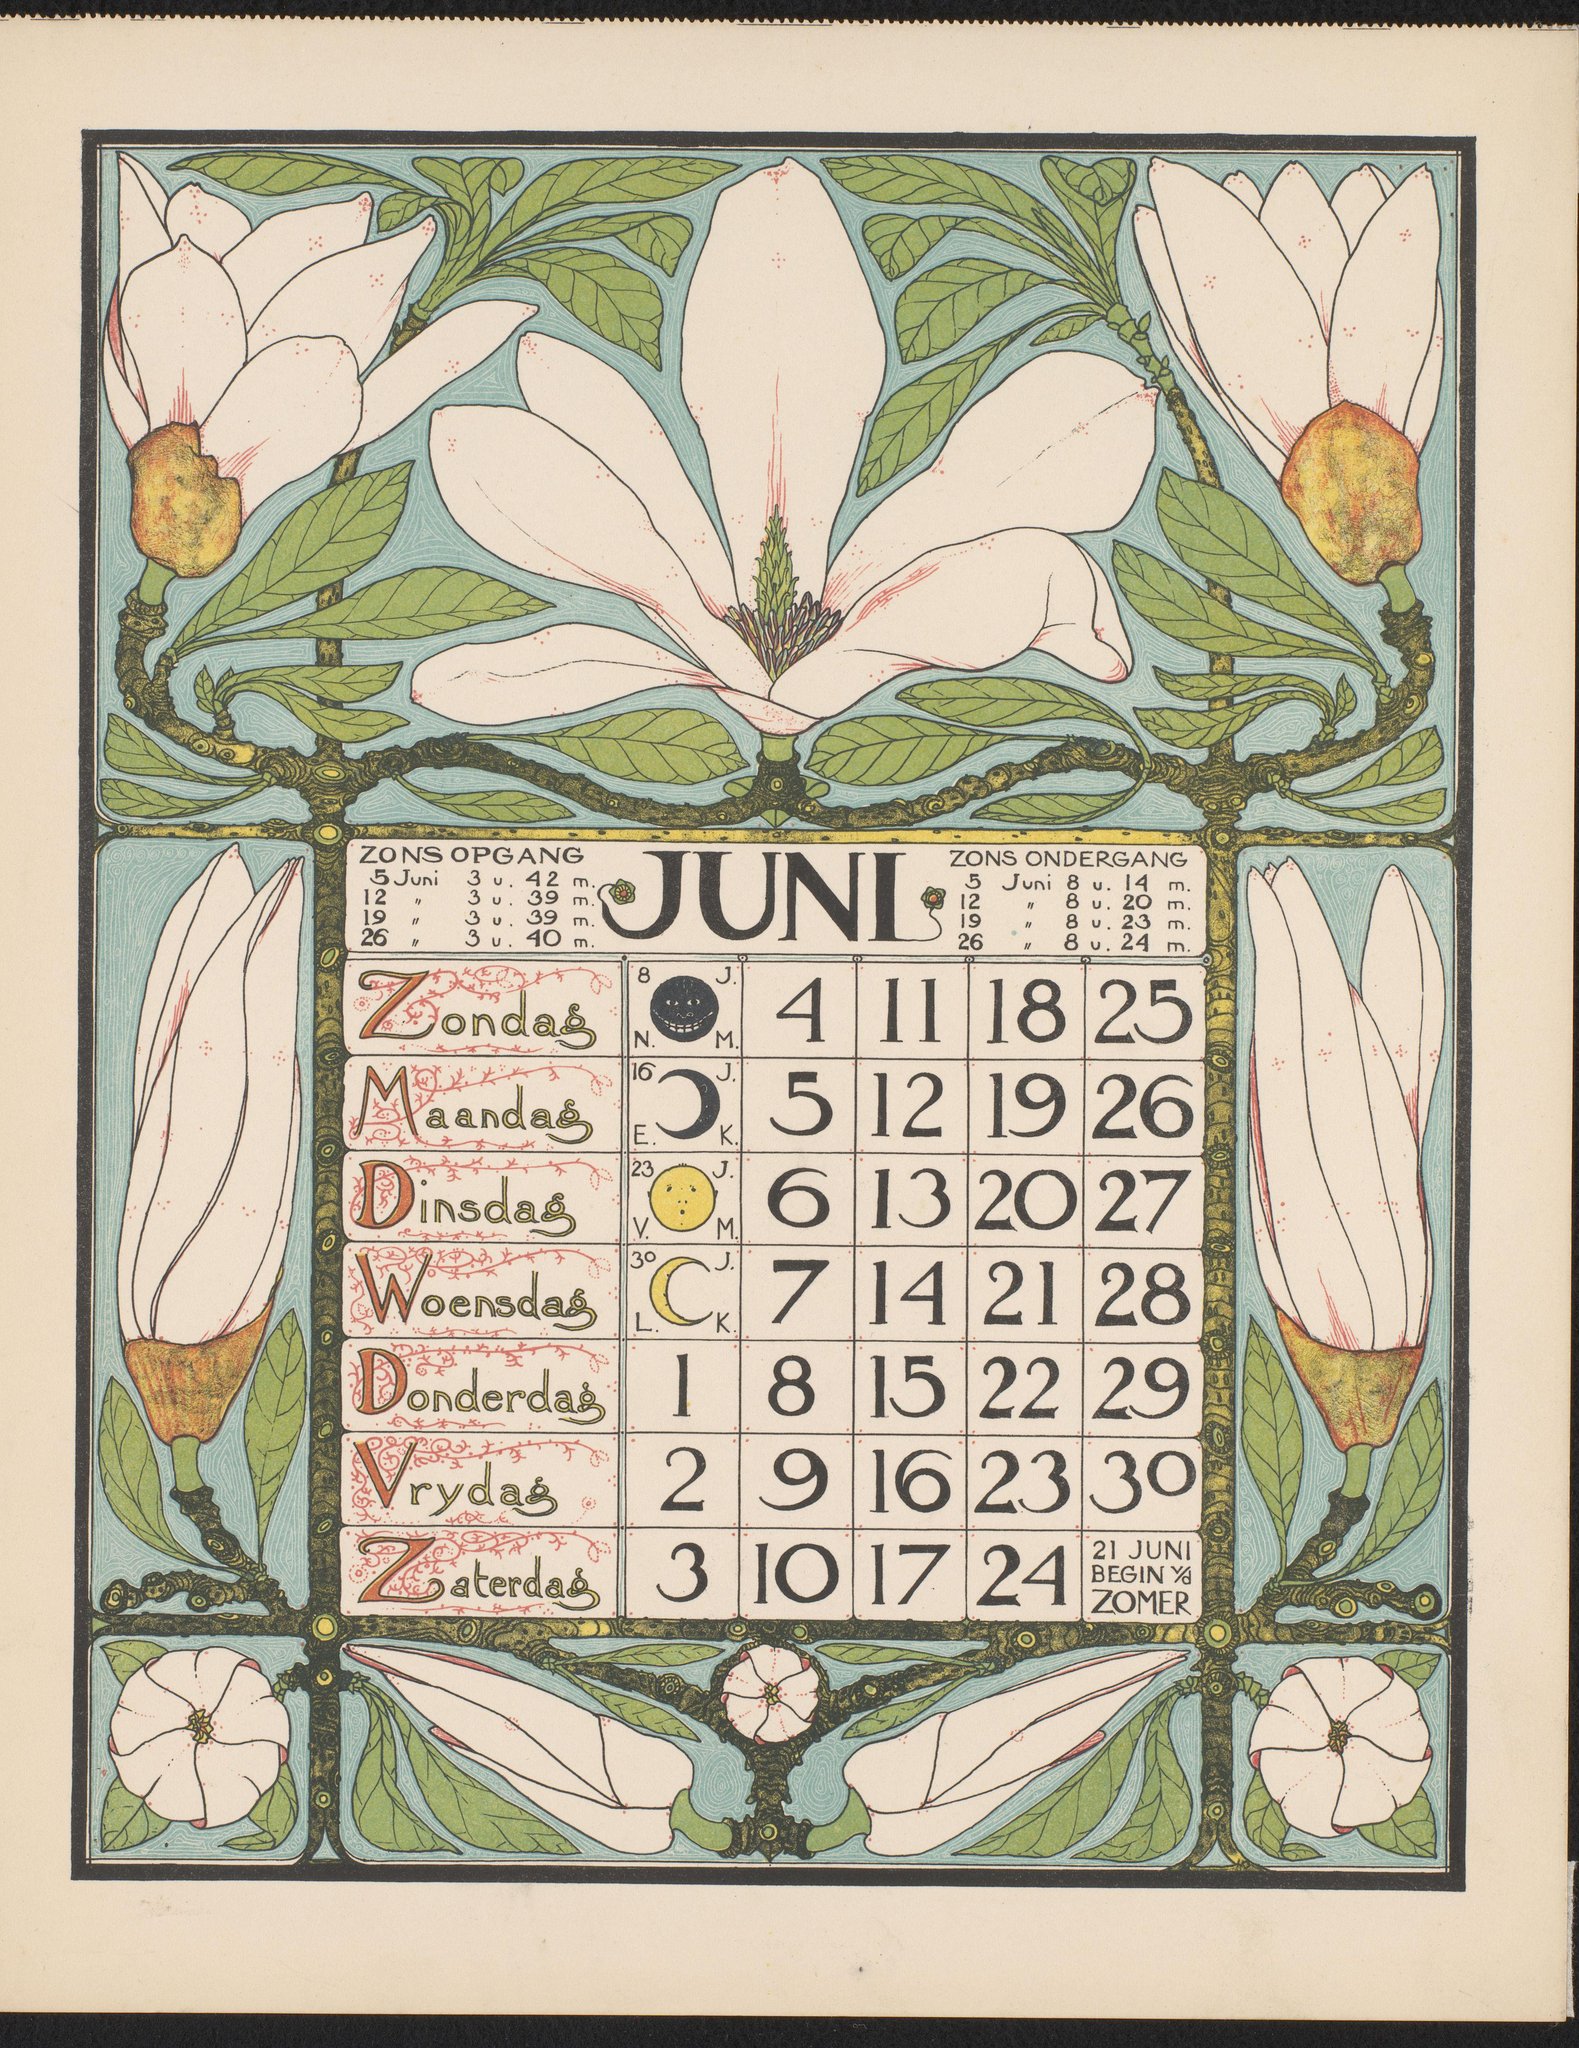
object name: calendar leaf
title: Kalenderblad voor juni 1899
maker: theo nieuwenhuis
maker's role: designer, draughtsman, print maker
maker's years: 1866-1951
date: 1898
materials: paper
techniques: lithograph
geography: amsterdam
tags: trees, calendar, almanac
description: Randdecoratie van bloeiende witte bloemen en takken rond de maandkalender, met daarbij een tabel van zonsopgang en zonsondergang. Bovenrand geperforeerd waar dit kalenderblad verbonden was met de rest van het jaar.